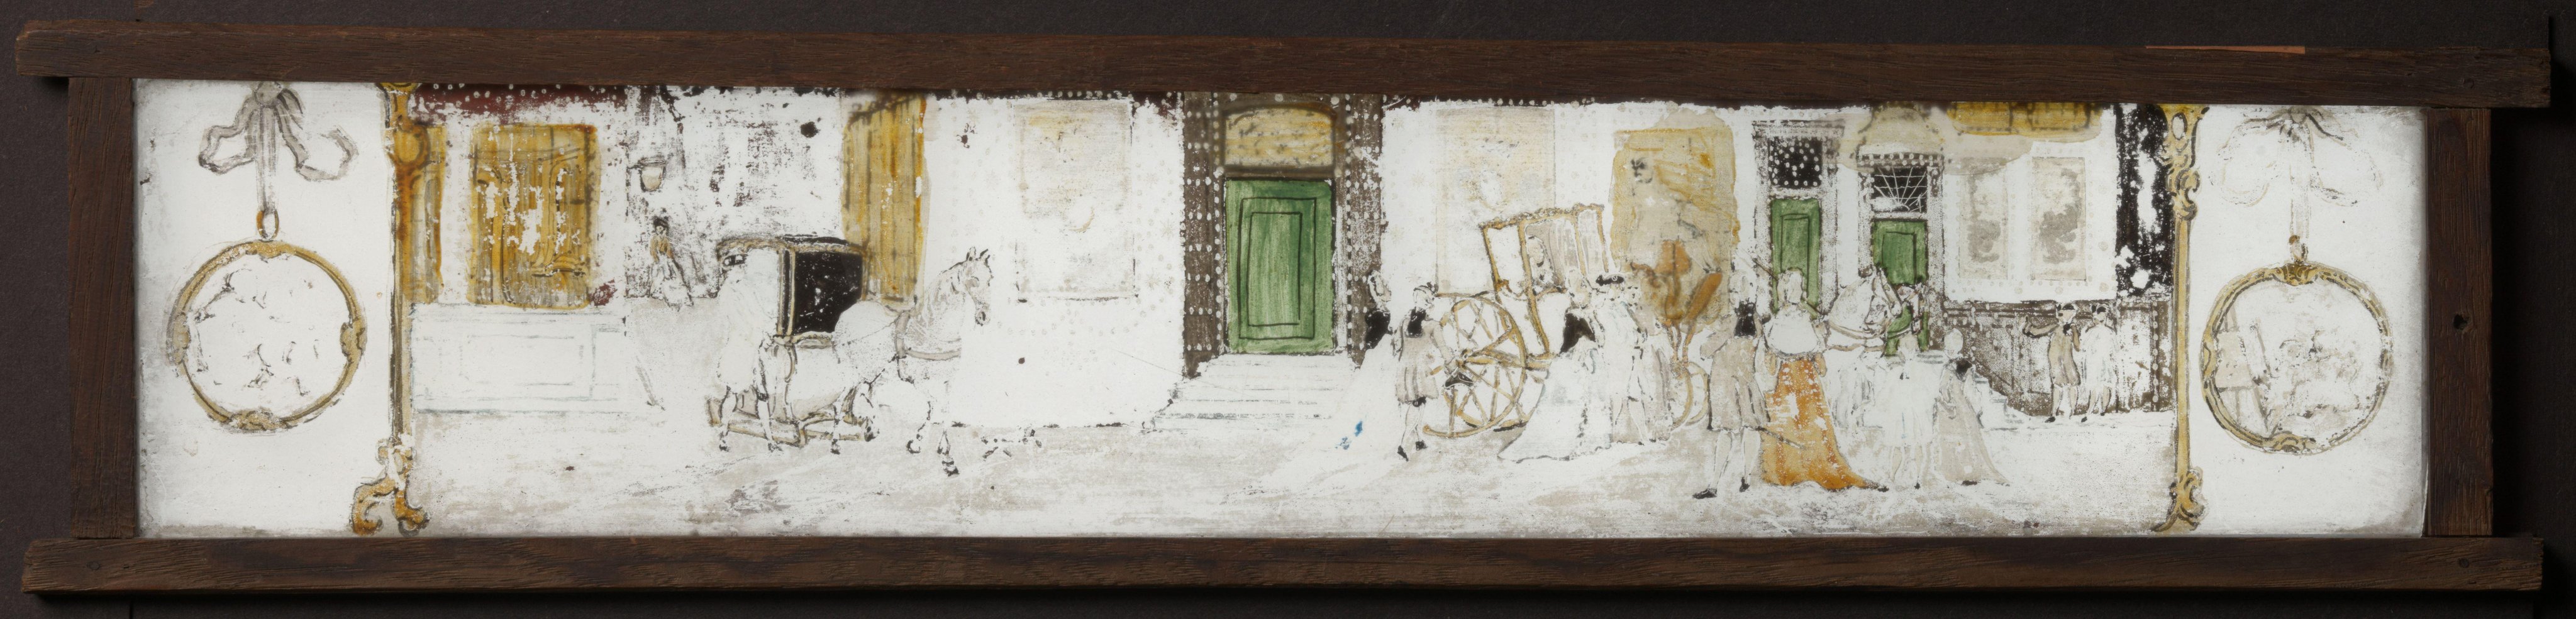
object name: lantern slide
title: De aankomst van personen bij een feest van rijke mensen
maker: Anonymous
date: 1750-1800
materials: glass, wood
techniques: painted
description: Houten frame met glasplaat, gebruikt voor toverlantaarn. De aankomst van personen bij een feest van rijke mensen. Mannen en vrouwen in mooie kleren lopen de trap van een huis op. Op de voorgrond is een koets zichtbaar, met lakeien daar omheen. Rechts komt nog een koets aanrijden.